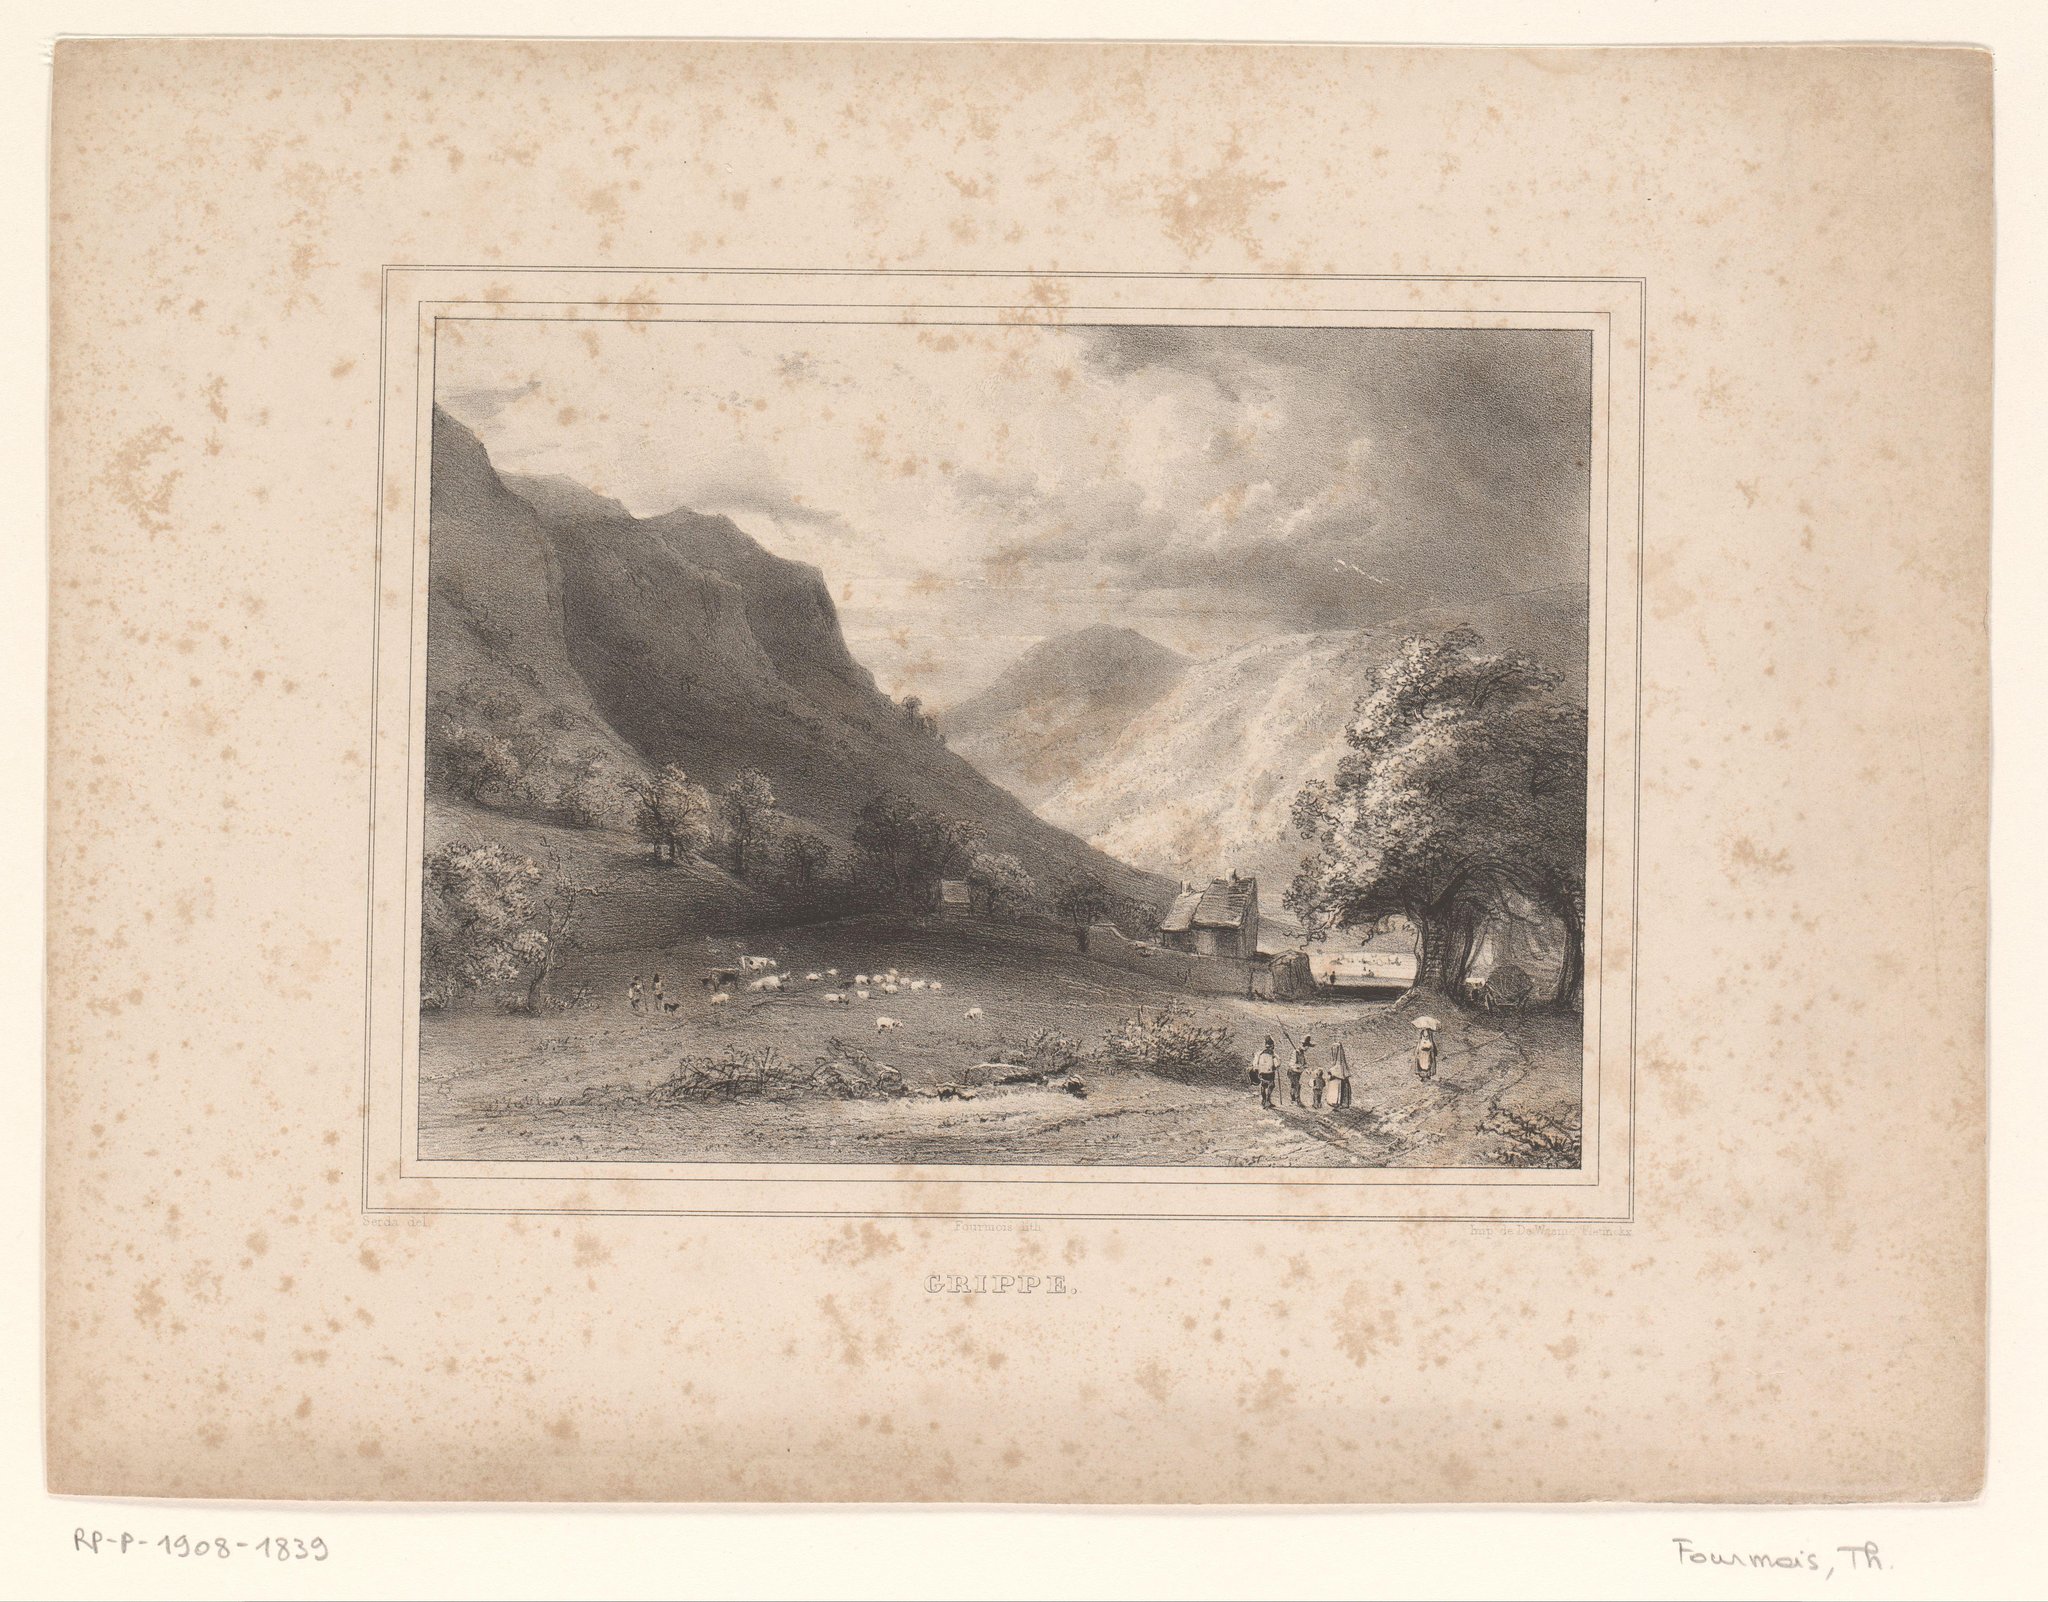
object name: print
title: Grippe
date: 1835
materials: paper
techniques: lithograph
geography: brussels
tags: dale, valley (+ landscape with figures, staffage), mountains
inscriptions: collector's mark: Lugt 2228